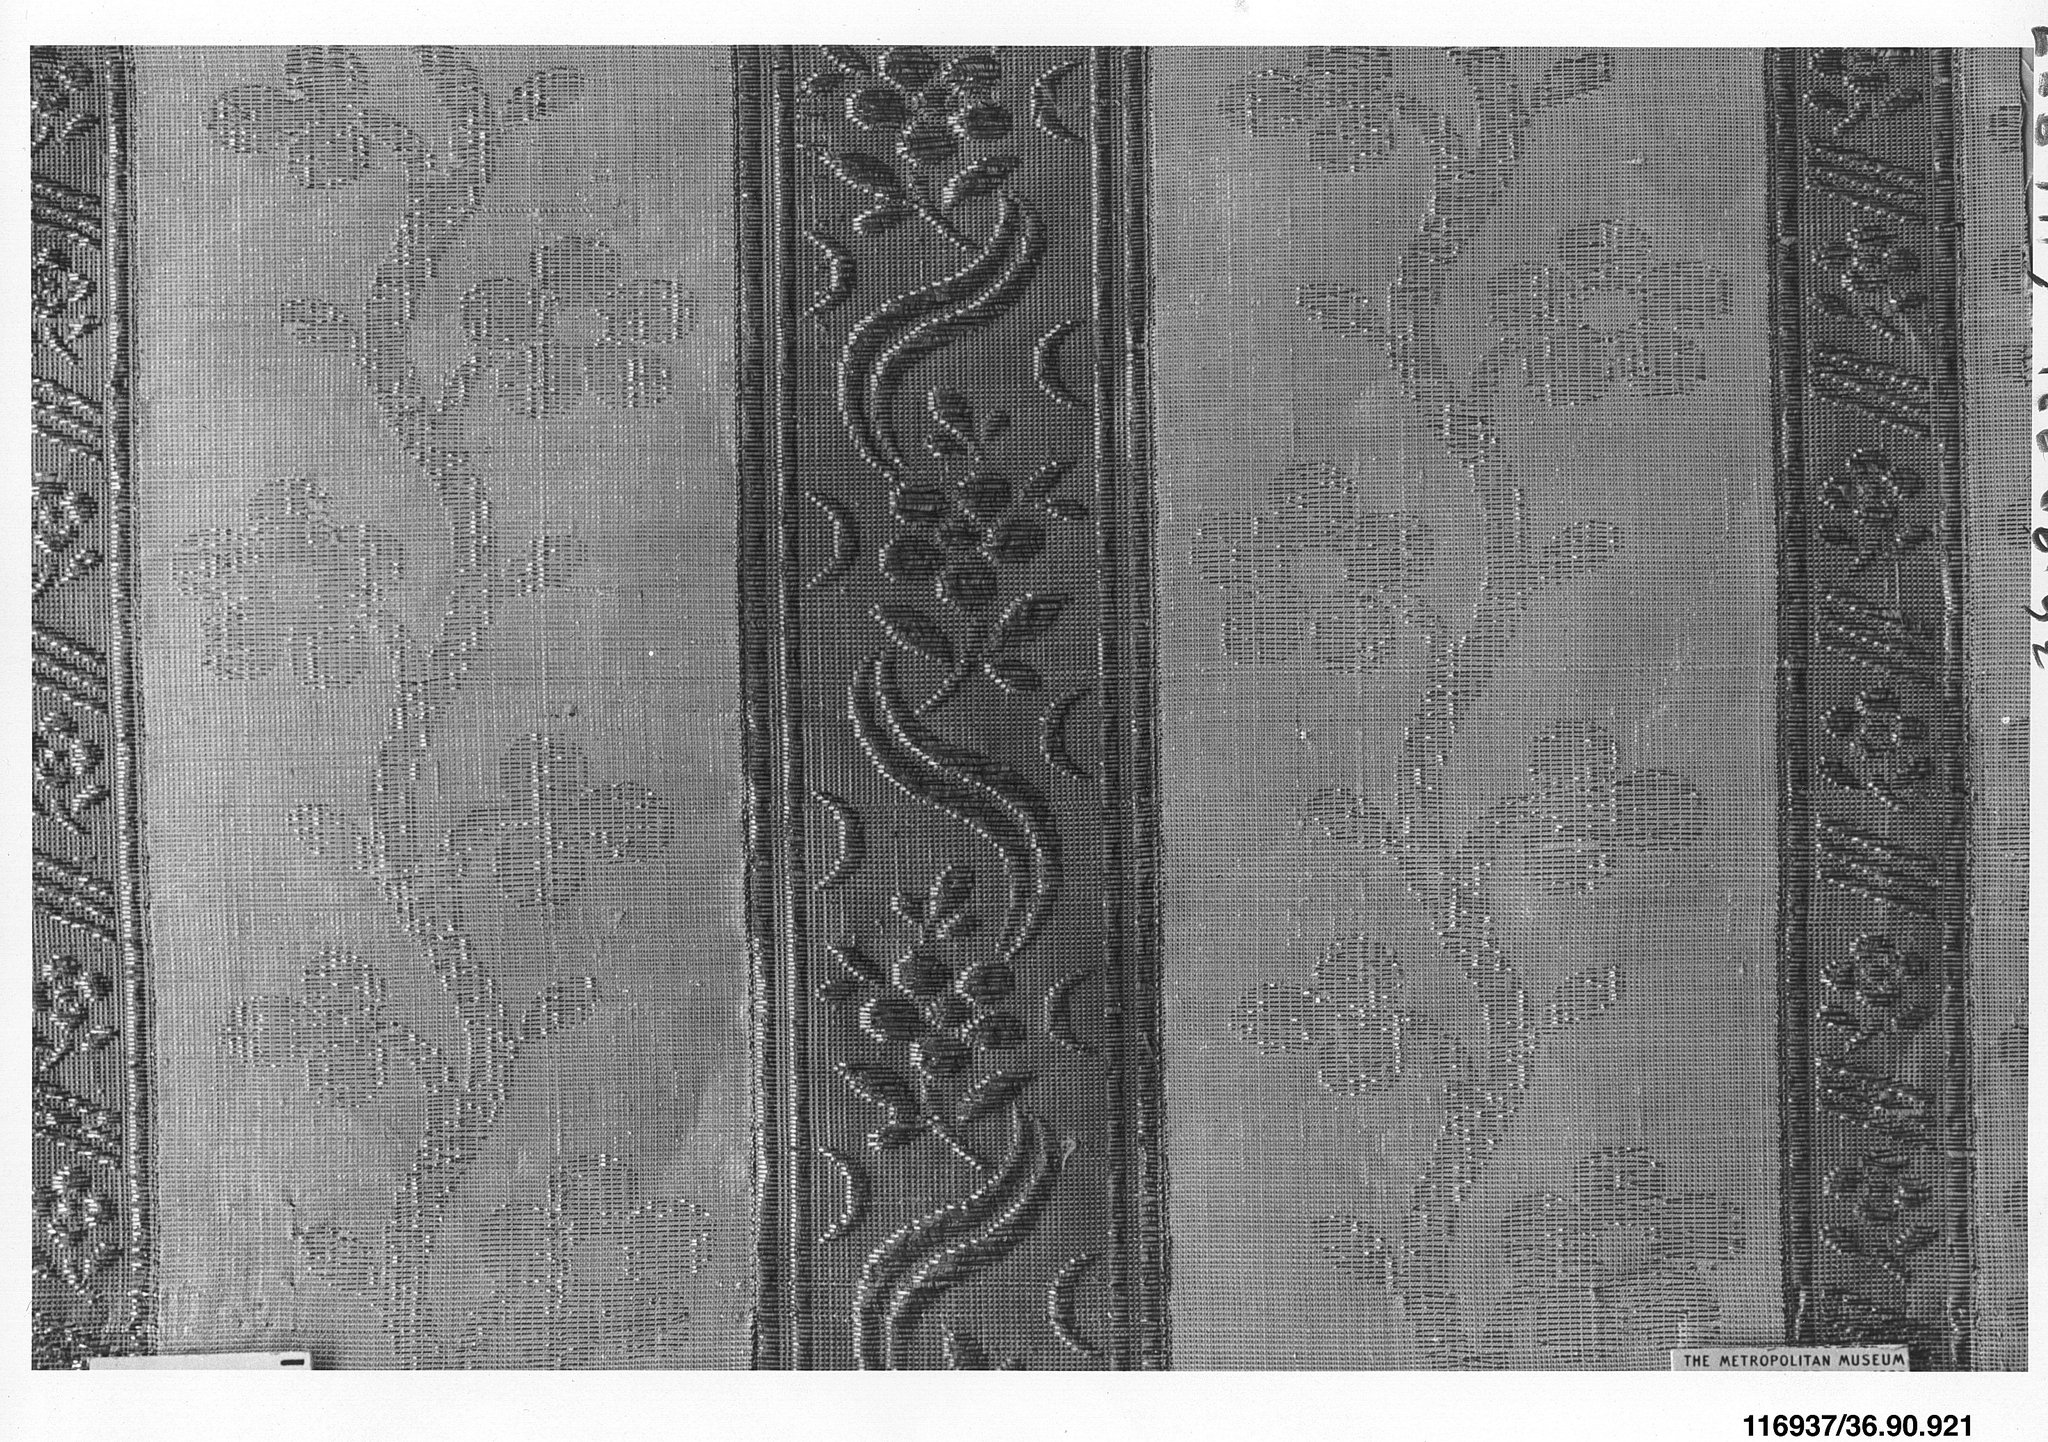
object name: piece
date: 1701-1800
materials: metal thread, silk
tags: flowers